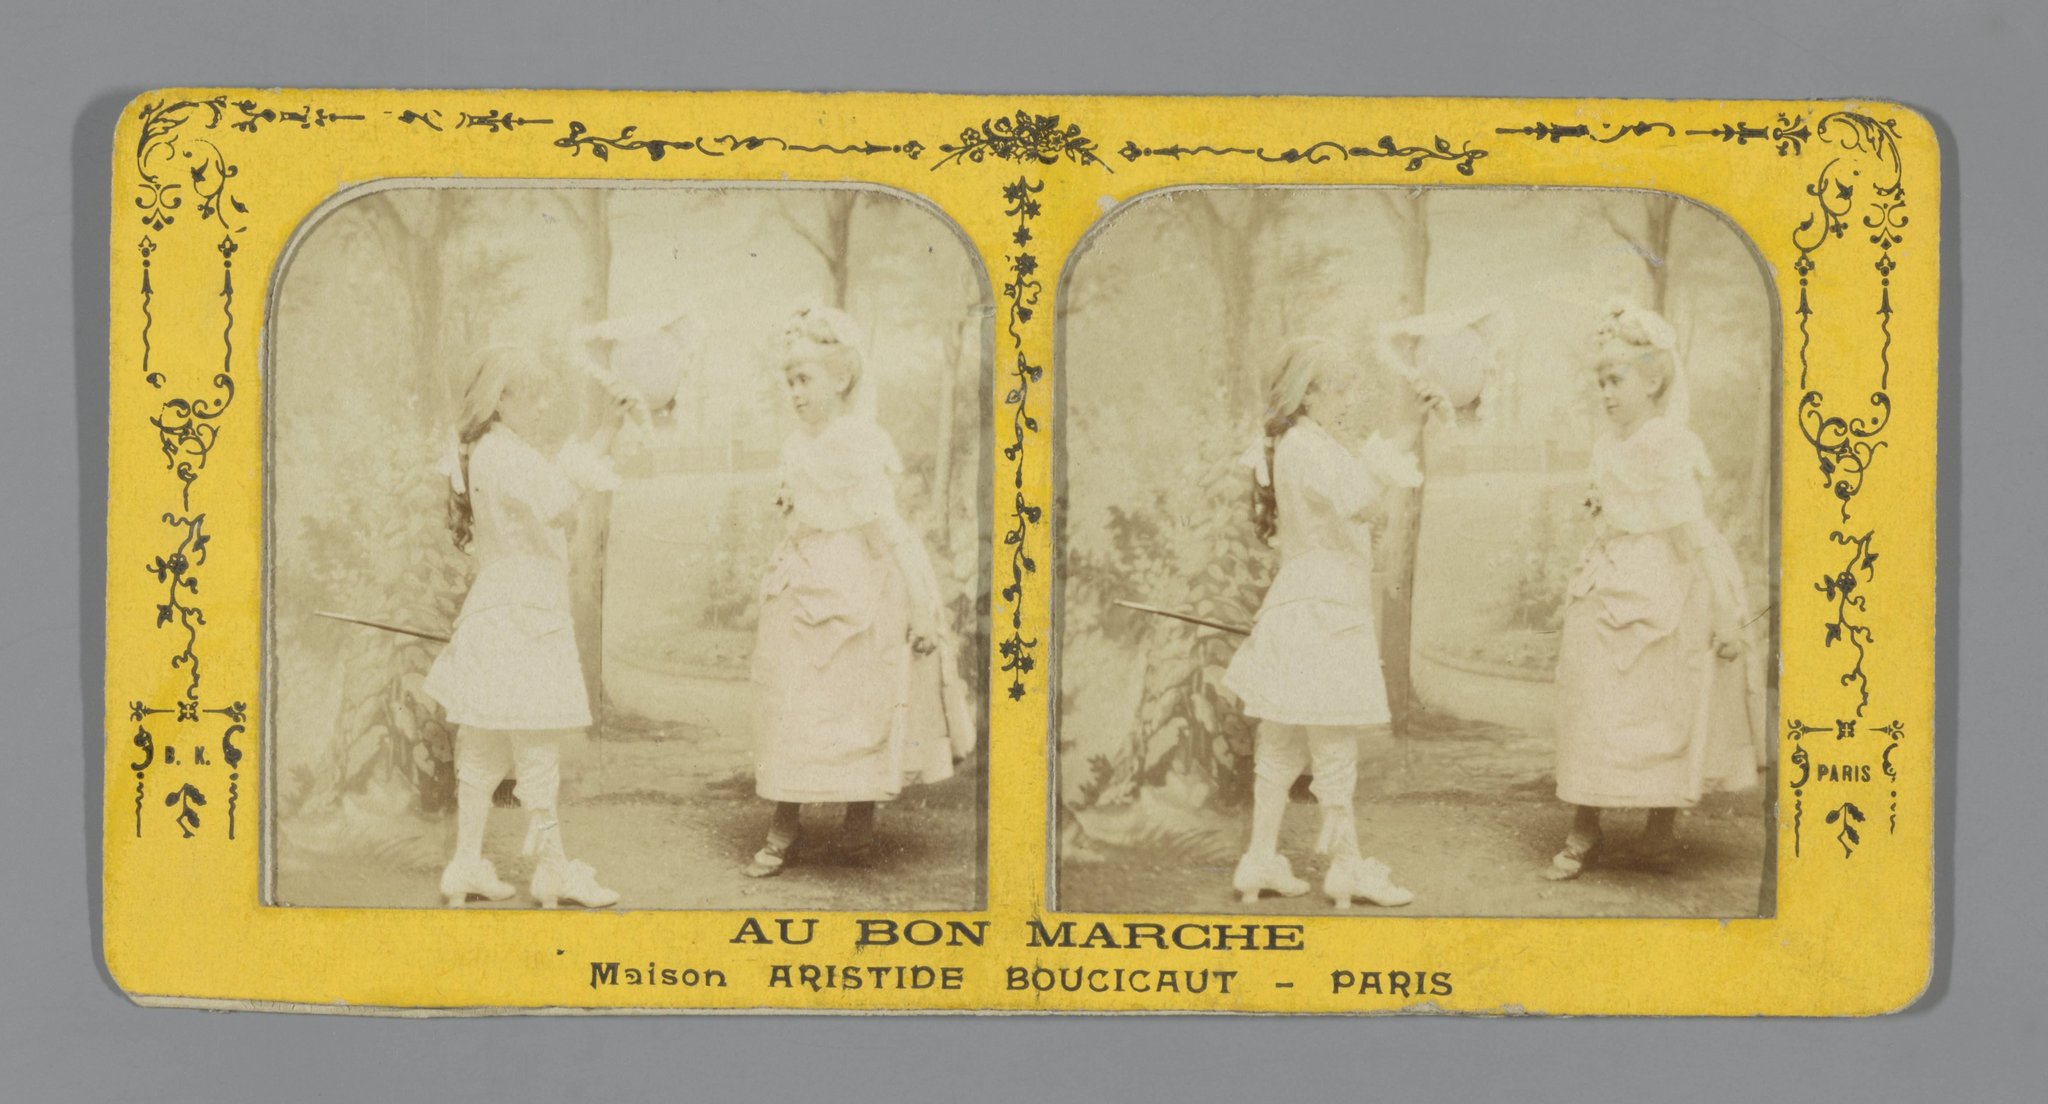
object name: tissue stereograph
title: Twee meisjes in historische kleding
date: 1863-1875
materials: cardboard, paper, photographic support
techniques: albumen print, hand coloring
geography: paris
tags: adolescent, young woman, maiden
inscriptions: retailer's mark: ‘AU BON MARCHE/ Maison ARTISTIDE BOUCICAUT - PARIS’